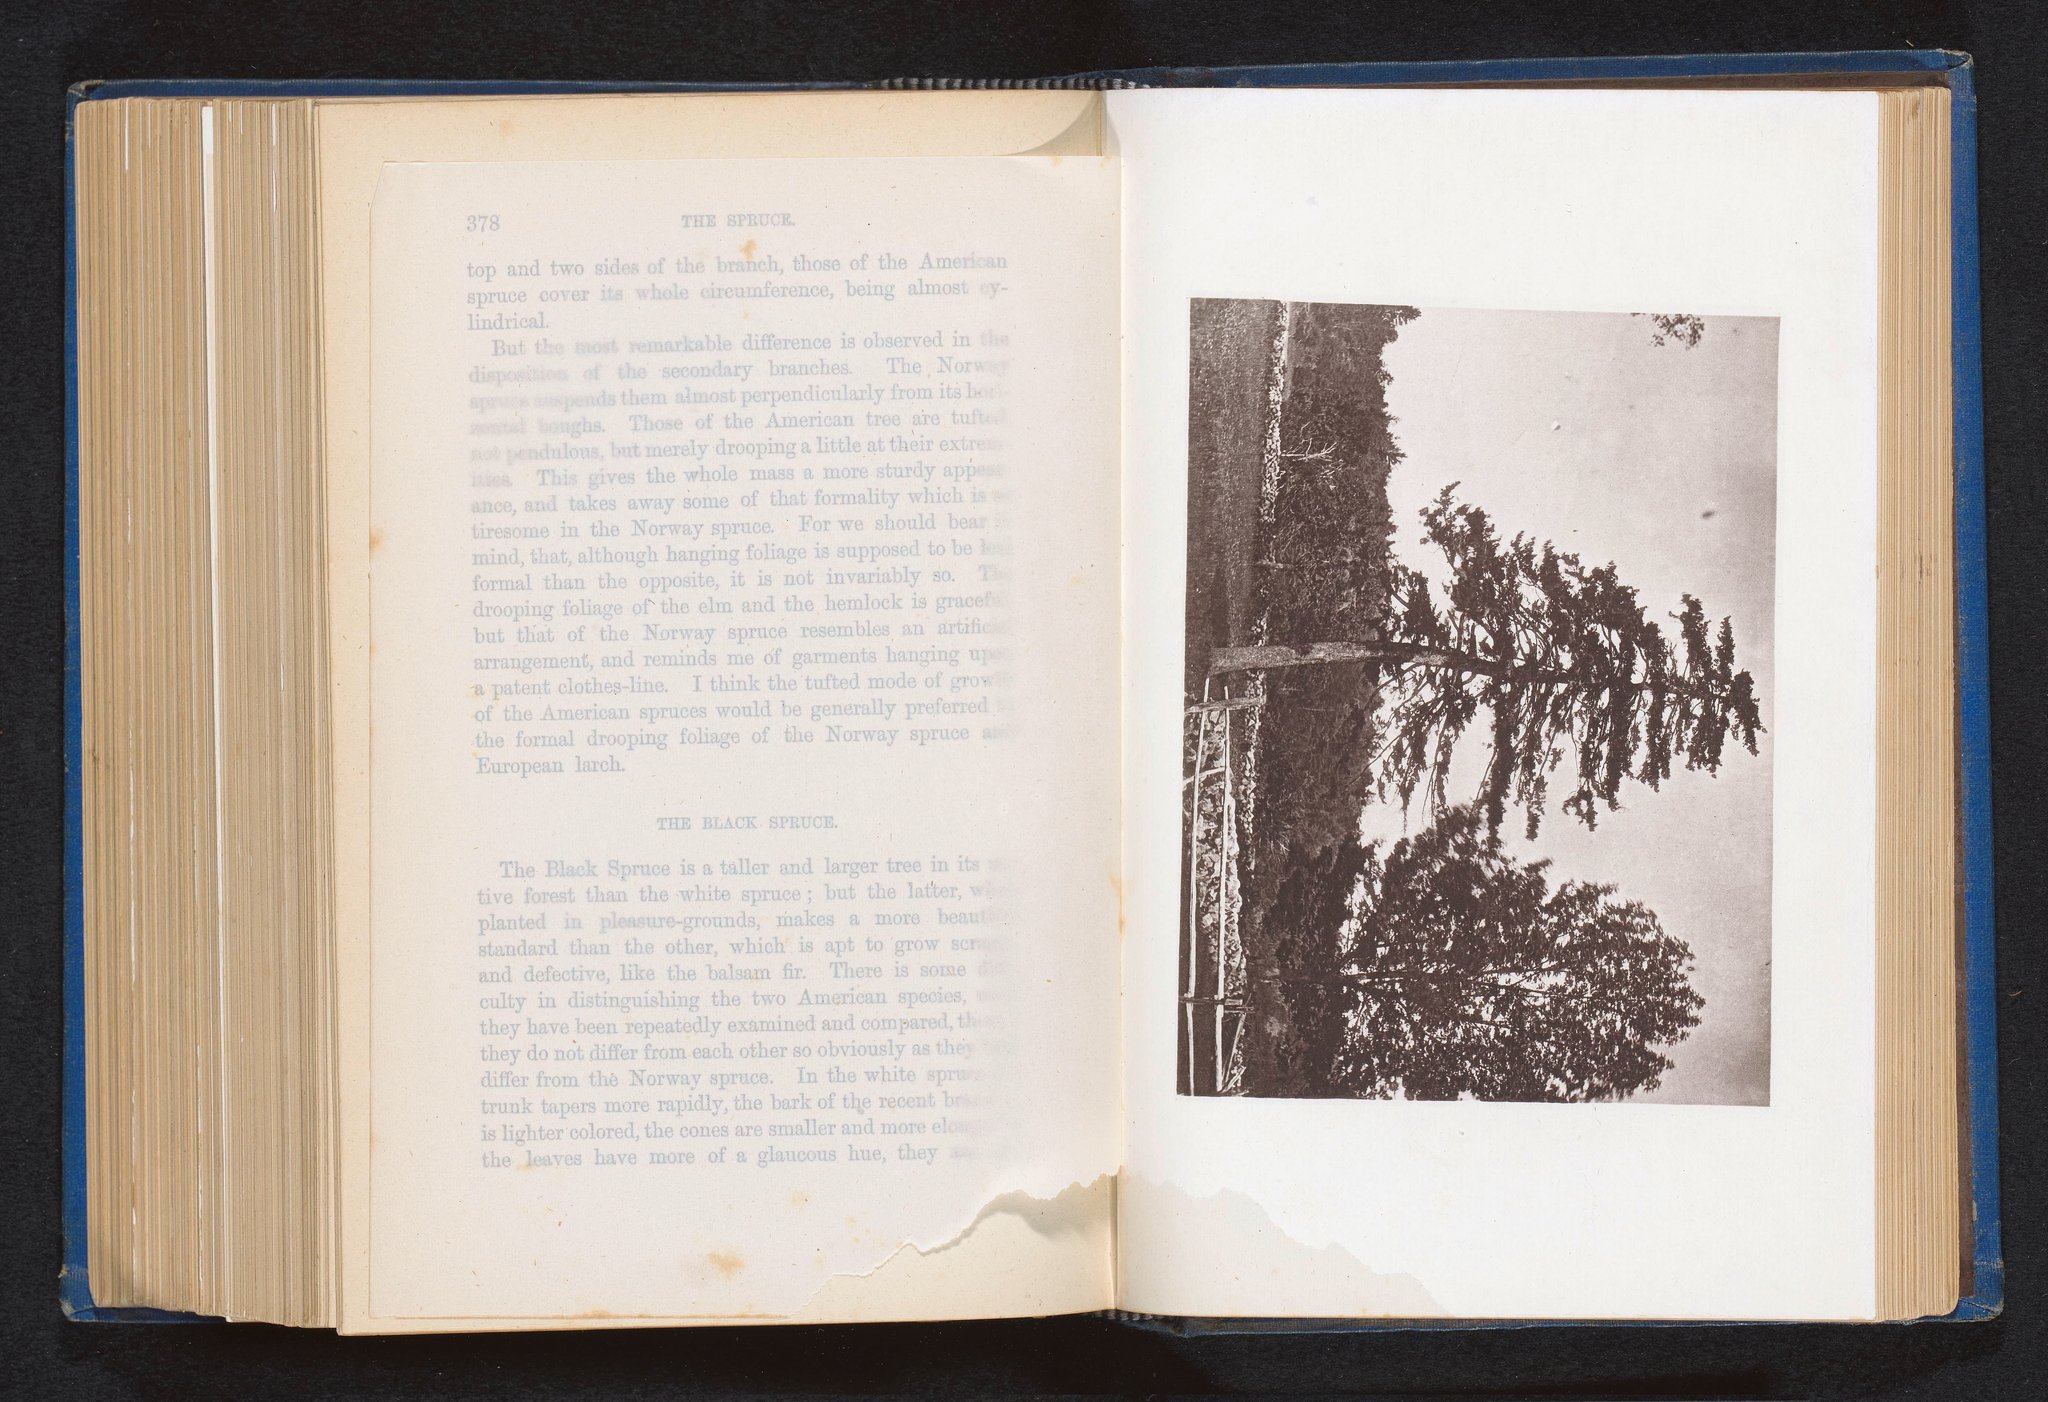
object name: page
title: Gezicht op een weide met een zwarte spar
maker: Anonymous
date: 1872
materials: paper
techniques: photograph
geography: saugus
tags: landscapes, meadow, pasture, trees: fir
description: Prent op eerste ongenummerde pagina na pagina 378.